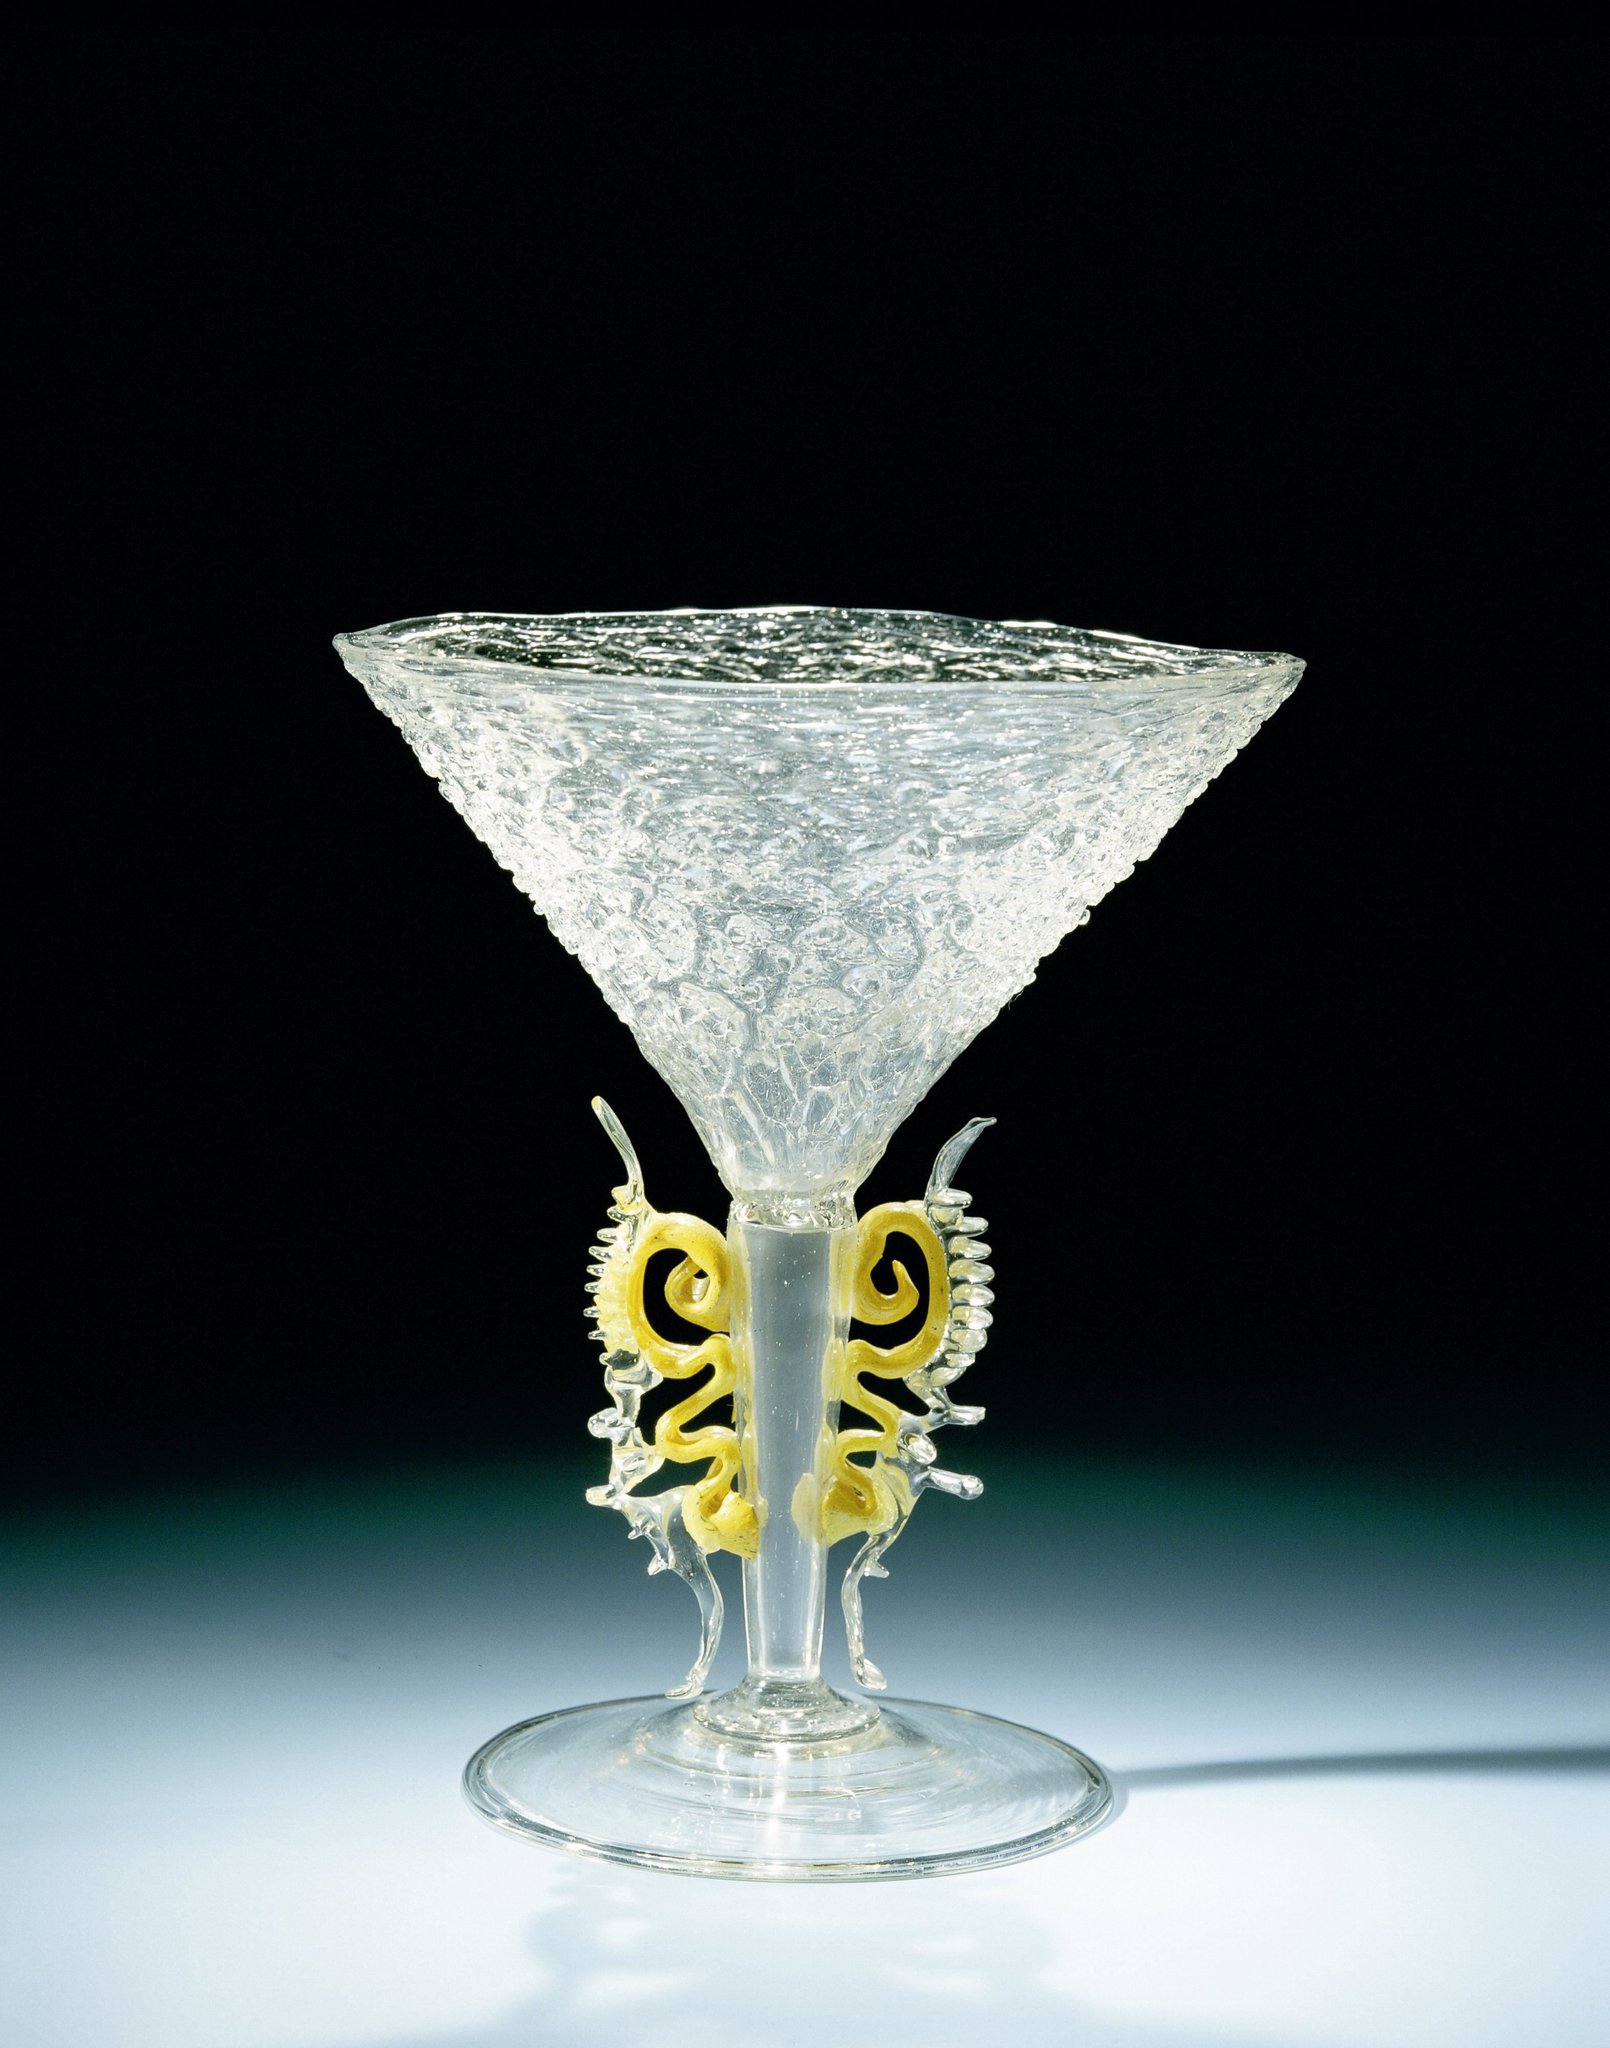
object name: goblet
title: Vleugelglas met twee vleugels in de vorm van zeepaardjes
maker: Anonymous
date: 1600-1625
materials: glass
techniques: façon de venise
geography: amsterdam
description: Wine glass. Amsterdam (?), façon de Venise, c. 1600- 1625. Gift of Mr. and Mrs. Engels-de Lange, 1999.